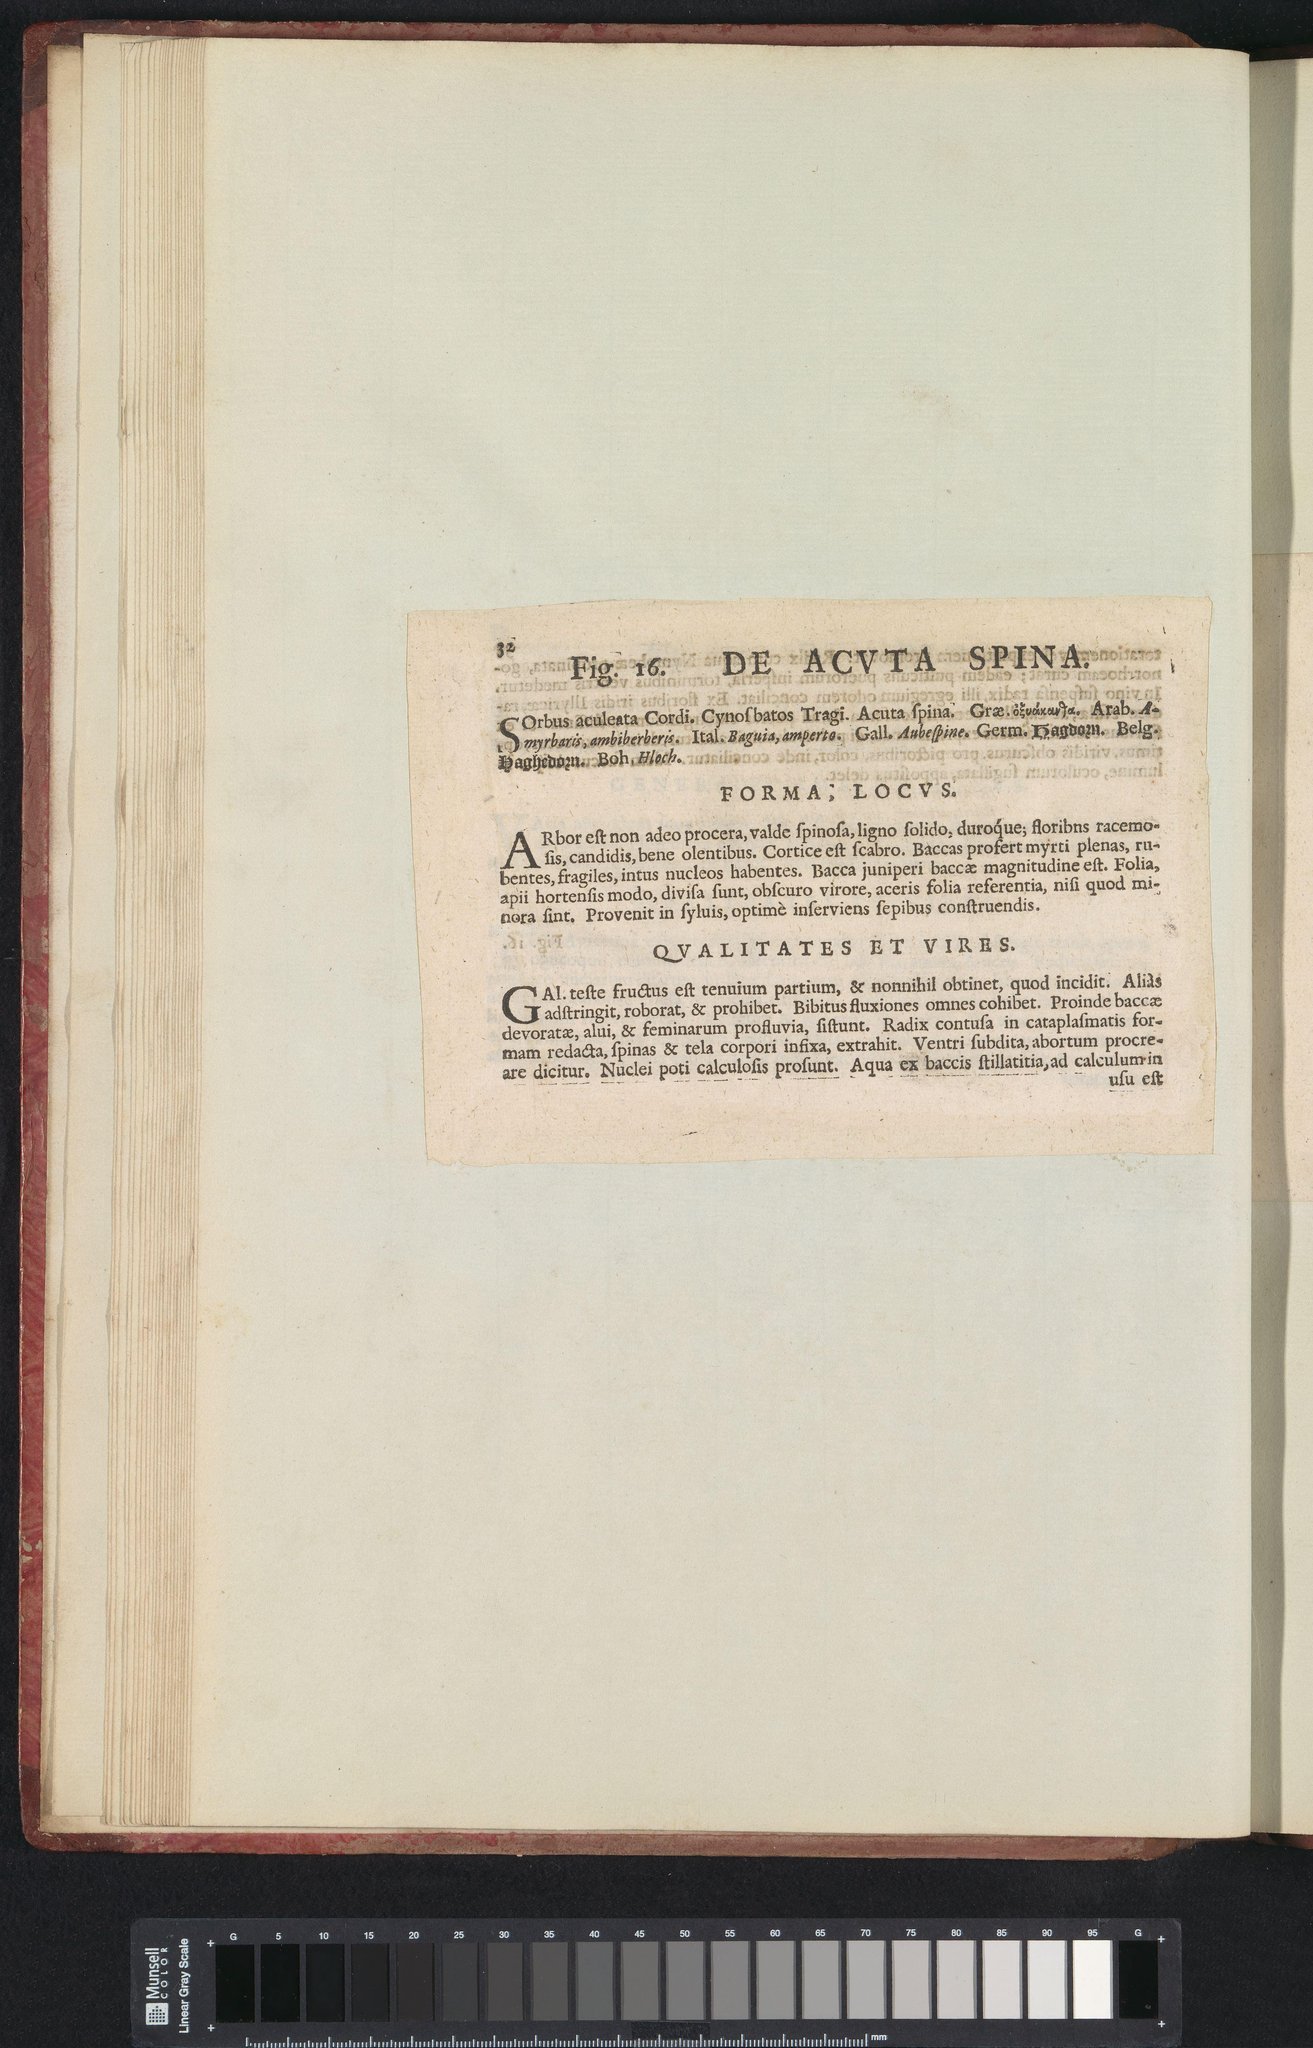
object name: text sheet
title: Fig. 16 'De Acvta Spina' in De Boodts herbarium van 1640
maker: anselmus boëtius de boodt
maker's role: draughtsman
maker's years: 1550-1632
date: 1640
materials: ink, paper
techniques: letterpress printing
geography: bruges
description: Beschrijving bij Fig. 16 op p. 32 in: Anselmi Boëtii de Boot I.C. Brugensis & Rodolphi II. Imp. Roman. medici a cubiculis Florum, Herbarum, ac fructuum selectiorum icones, & vires pleraeque hactenus ignotæ. Onderdeel van het album met bladen en platen uit De Boodts herbarium van 1640. Het twaalfde van twaalf albums met aquarellen van dieren, vogels en planten bekend rond 1600, gemaakt in opdracht van keizer Rudolf II.